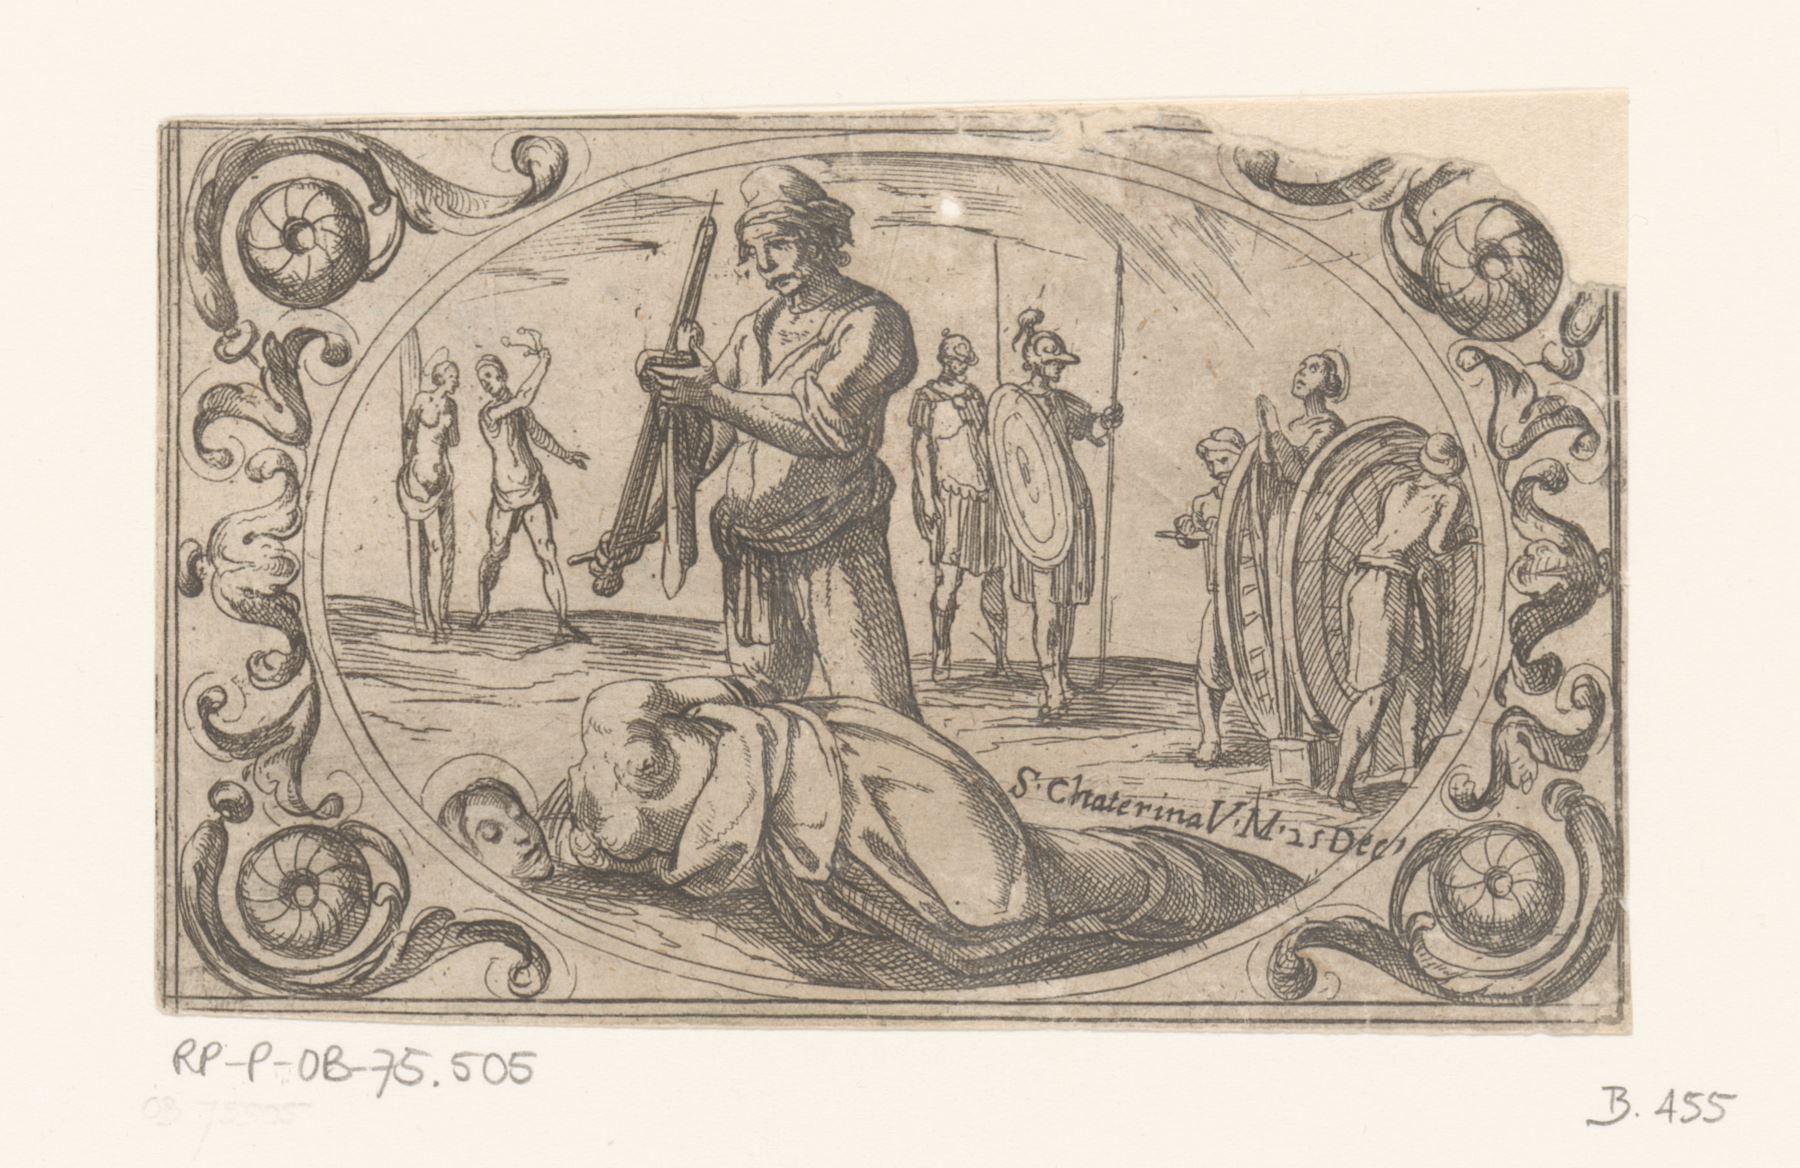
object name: print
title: H. Catharina van Alexandrië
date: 1565-1630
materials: paper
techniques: etching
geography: rome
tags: the virgin martyr catherine of alexandria; possible attributes: book, crown, emperor maxentius, palm-branch, ring, sword, wheel, martyr(s) (often with palm-branches) - qq - female martyr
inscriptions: collector's mark: Lugt 240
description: Deze prent maakt deel uit van een reeks van 73 prenten (+ titelprent) met voorstellingen van Romeinse martelaressen.